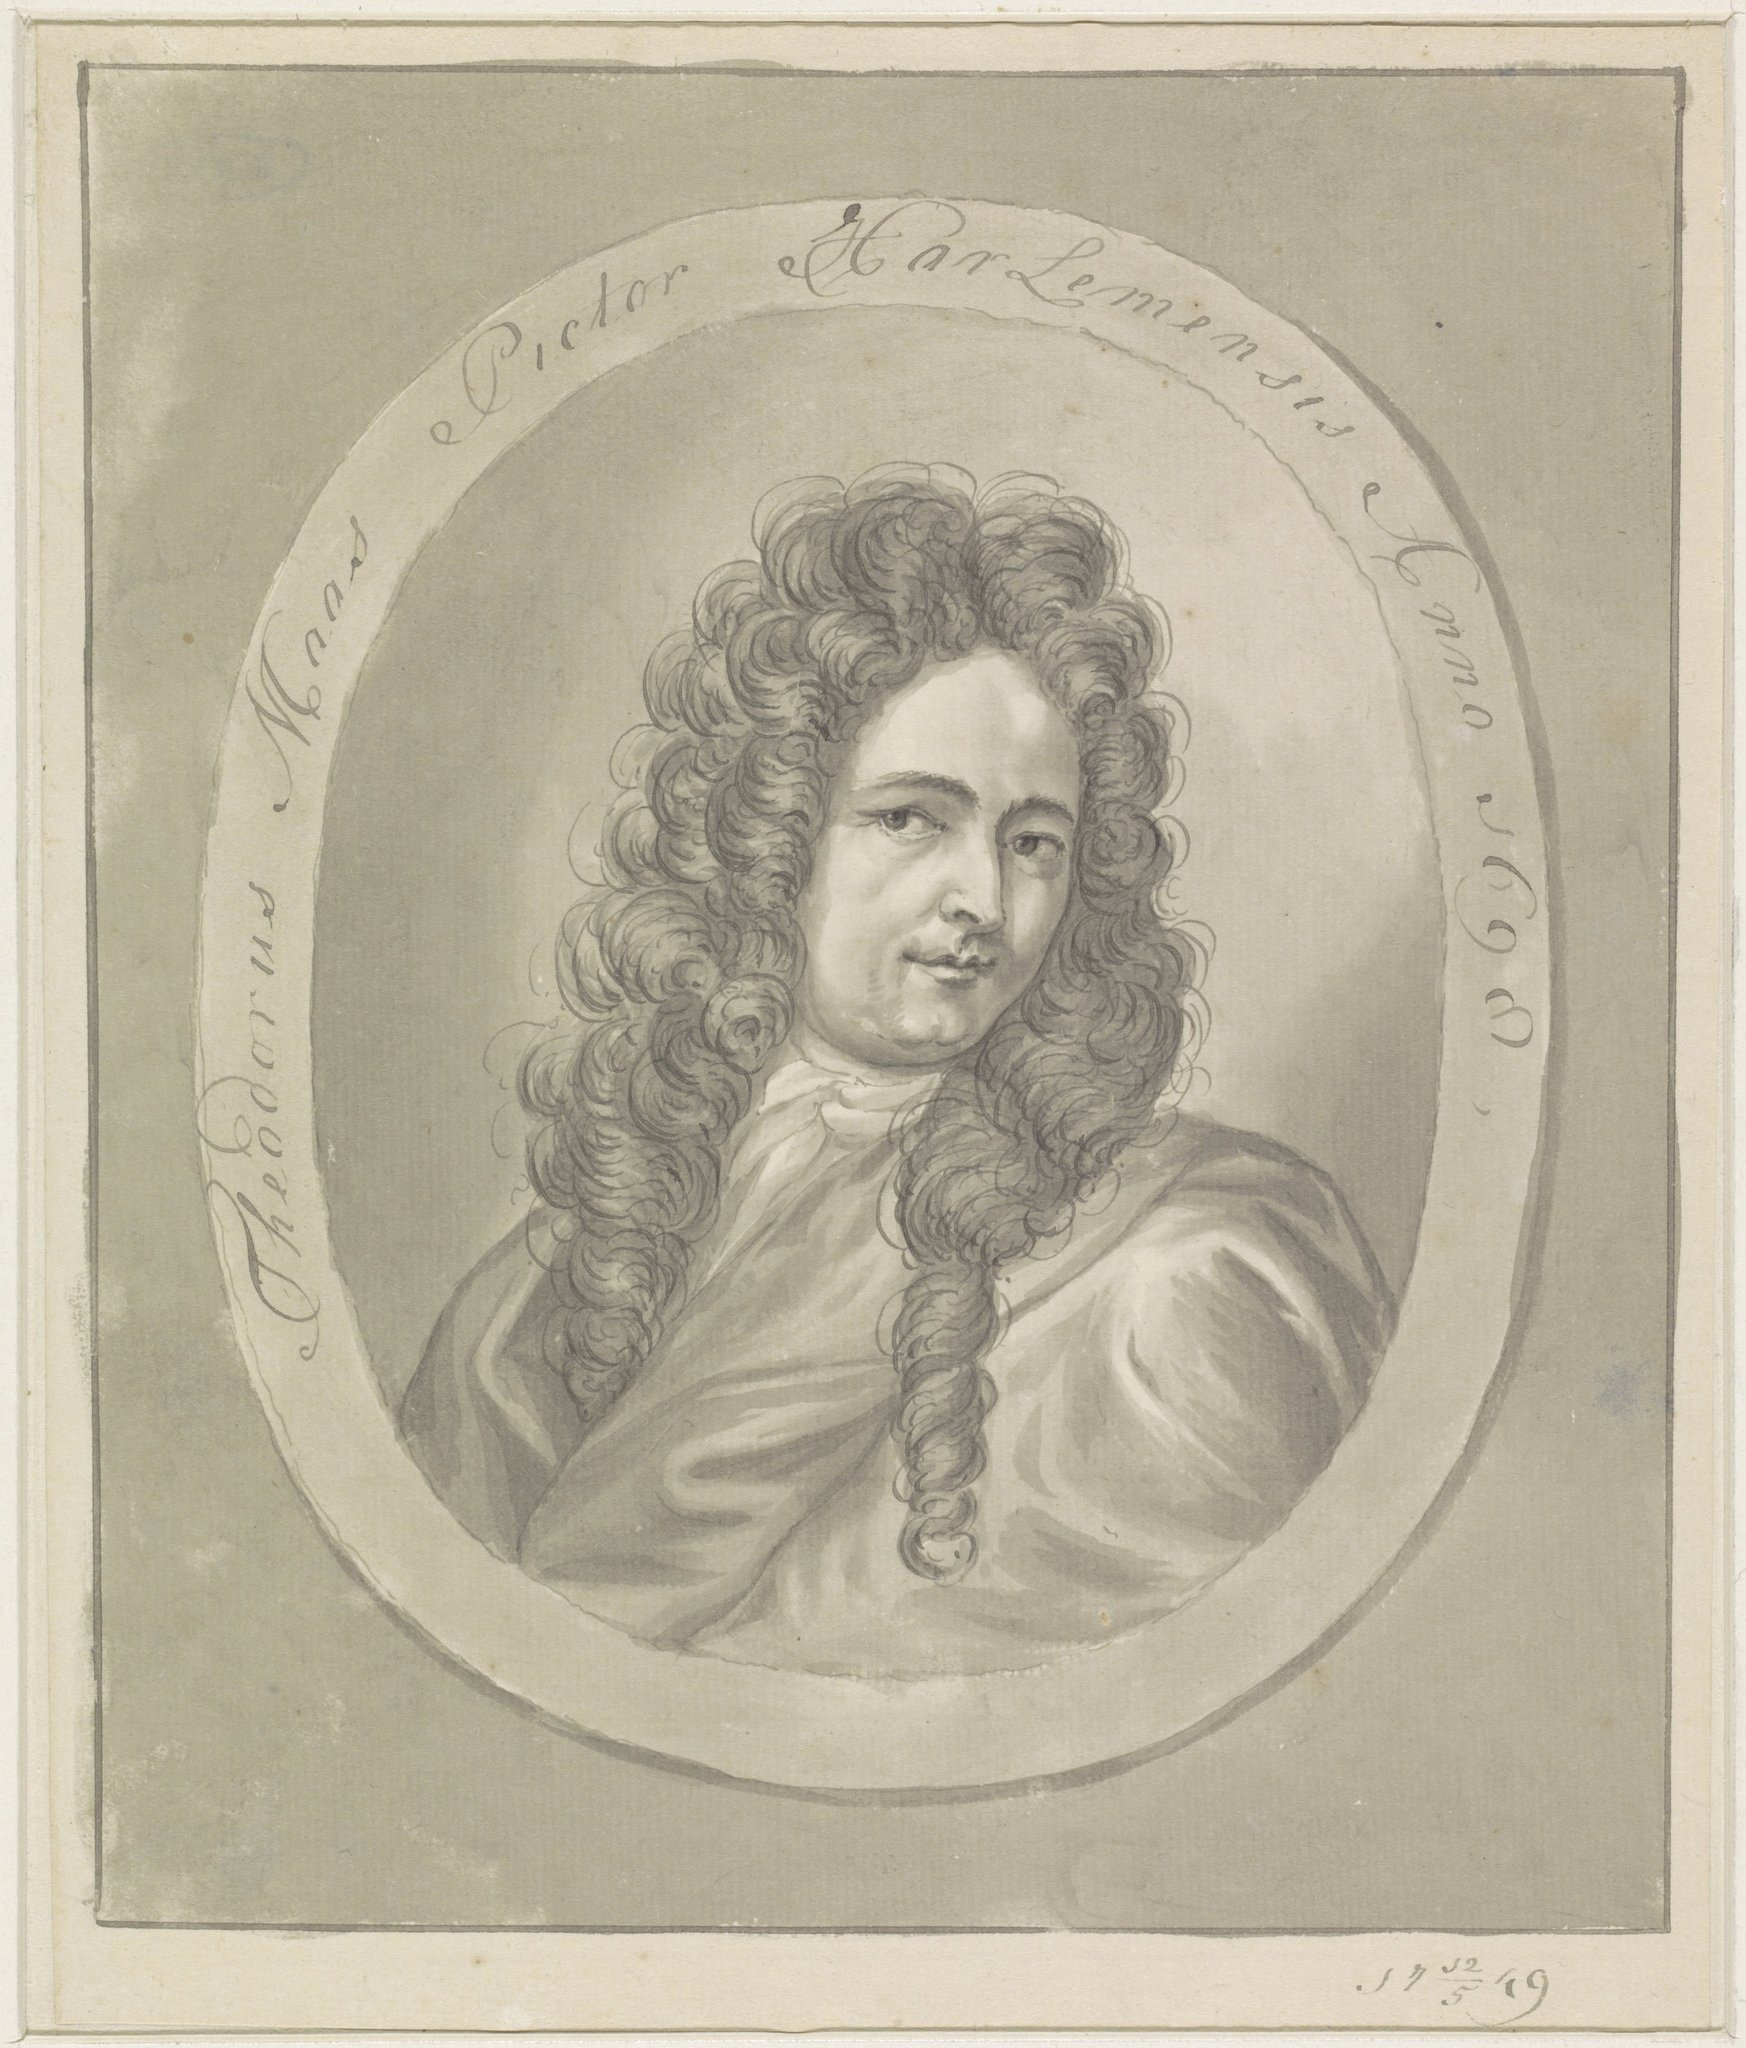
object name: drawing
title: Portret van Dirk Maes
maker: Anonymous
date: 1749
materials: ink, paper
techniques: pen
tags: haarlem, draughtsman, dirk maas, historical persons, portrait, self-portrait of painter, portrait, self-portrait of artist